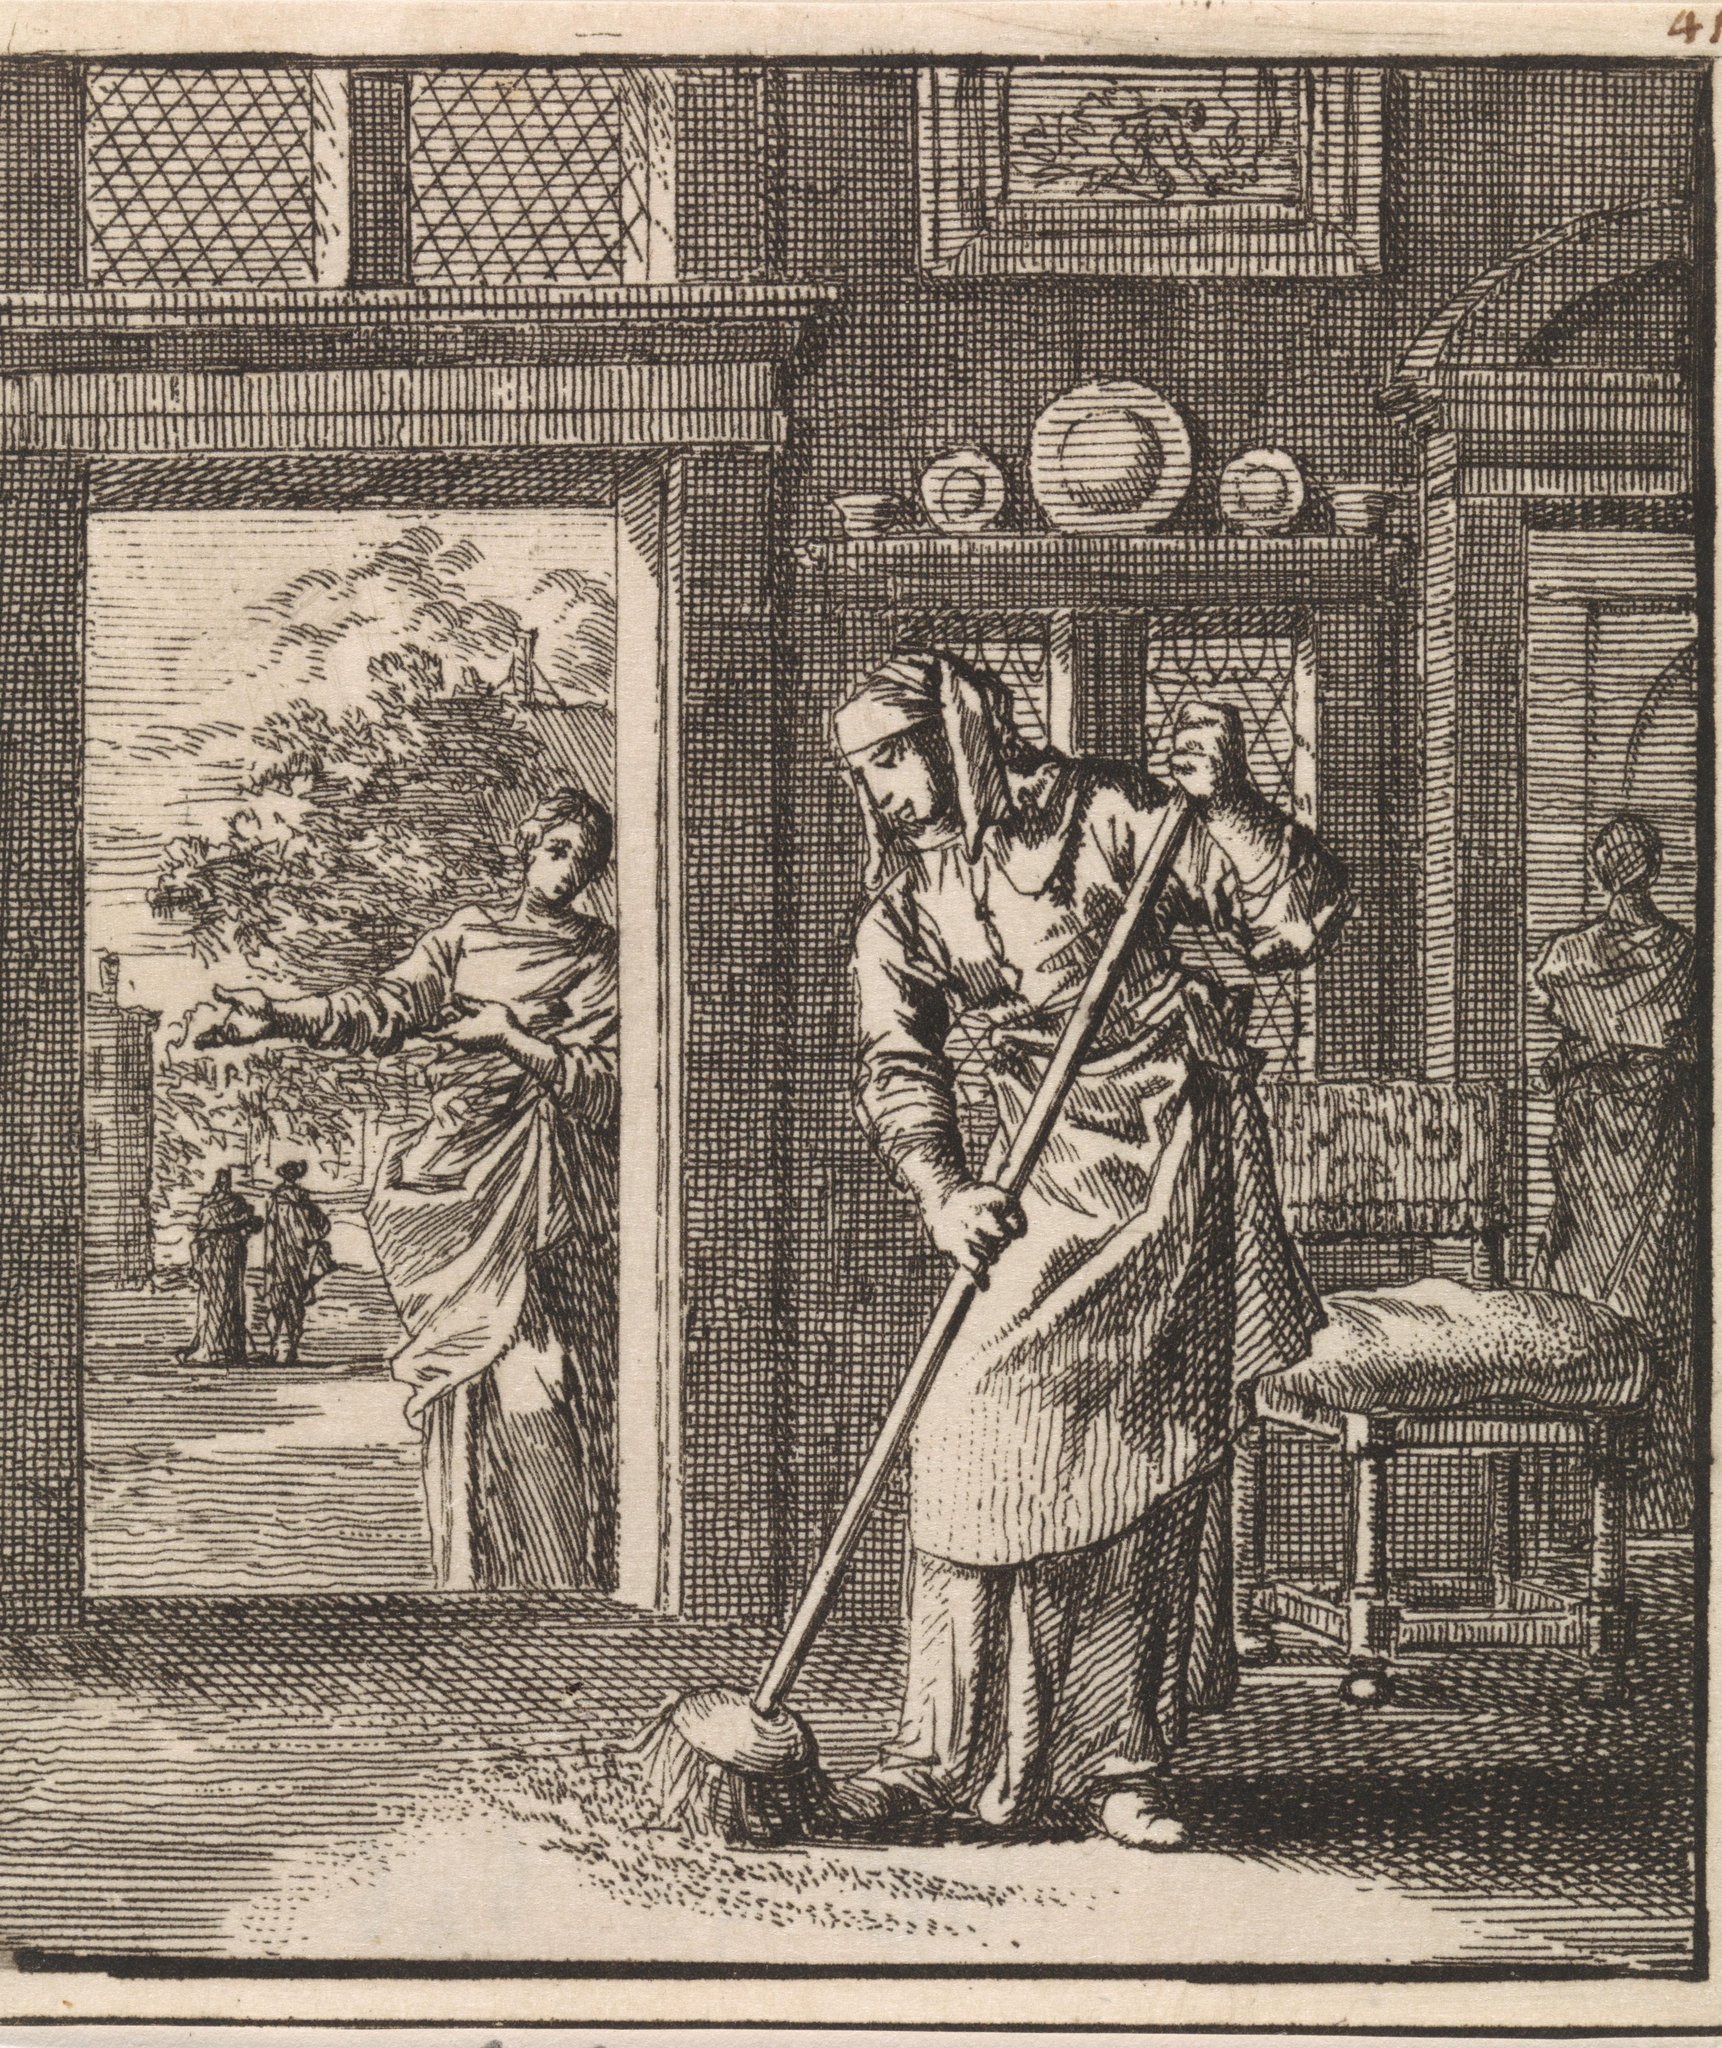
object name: print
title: De Bezem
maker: jan luyken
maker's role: draughtsman, print maker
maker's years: 1649-1712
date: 1711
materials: paper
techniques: etching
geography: amsterdam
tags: shrubs: broom, sweeping (~ cleaning the house)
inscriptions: collector's mark: Lugt 2228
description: Proefdruk van illustratie voor: Luyken, Jan. Het leerzaam huisraad, vertoond in vyftig konstige figuuren, met godlyke spreuken en stichtelyke verzen: Pieter Arentsz. II (wed.) en Cornelis van der Sys, 1711, p. 146.